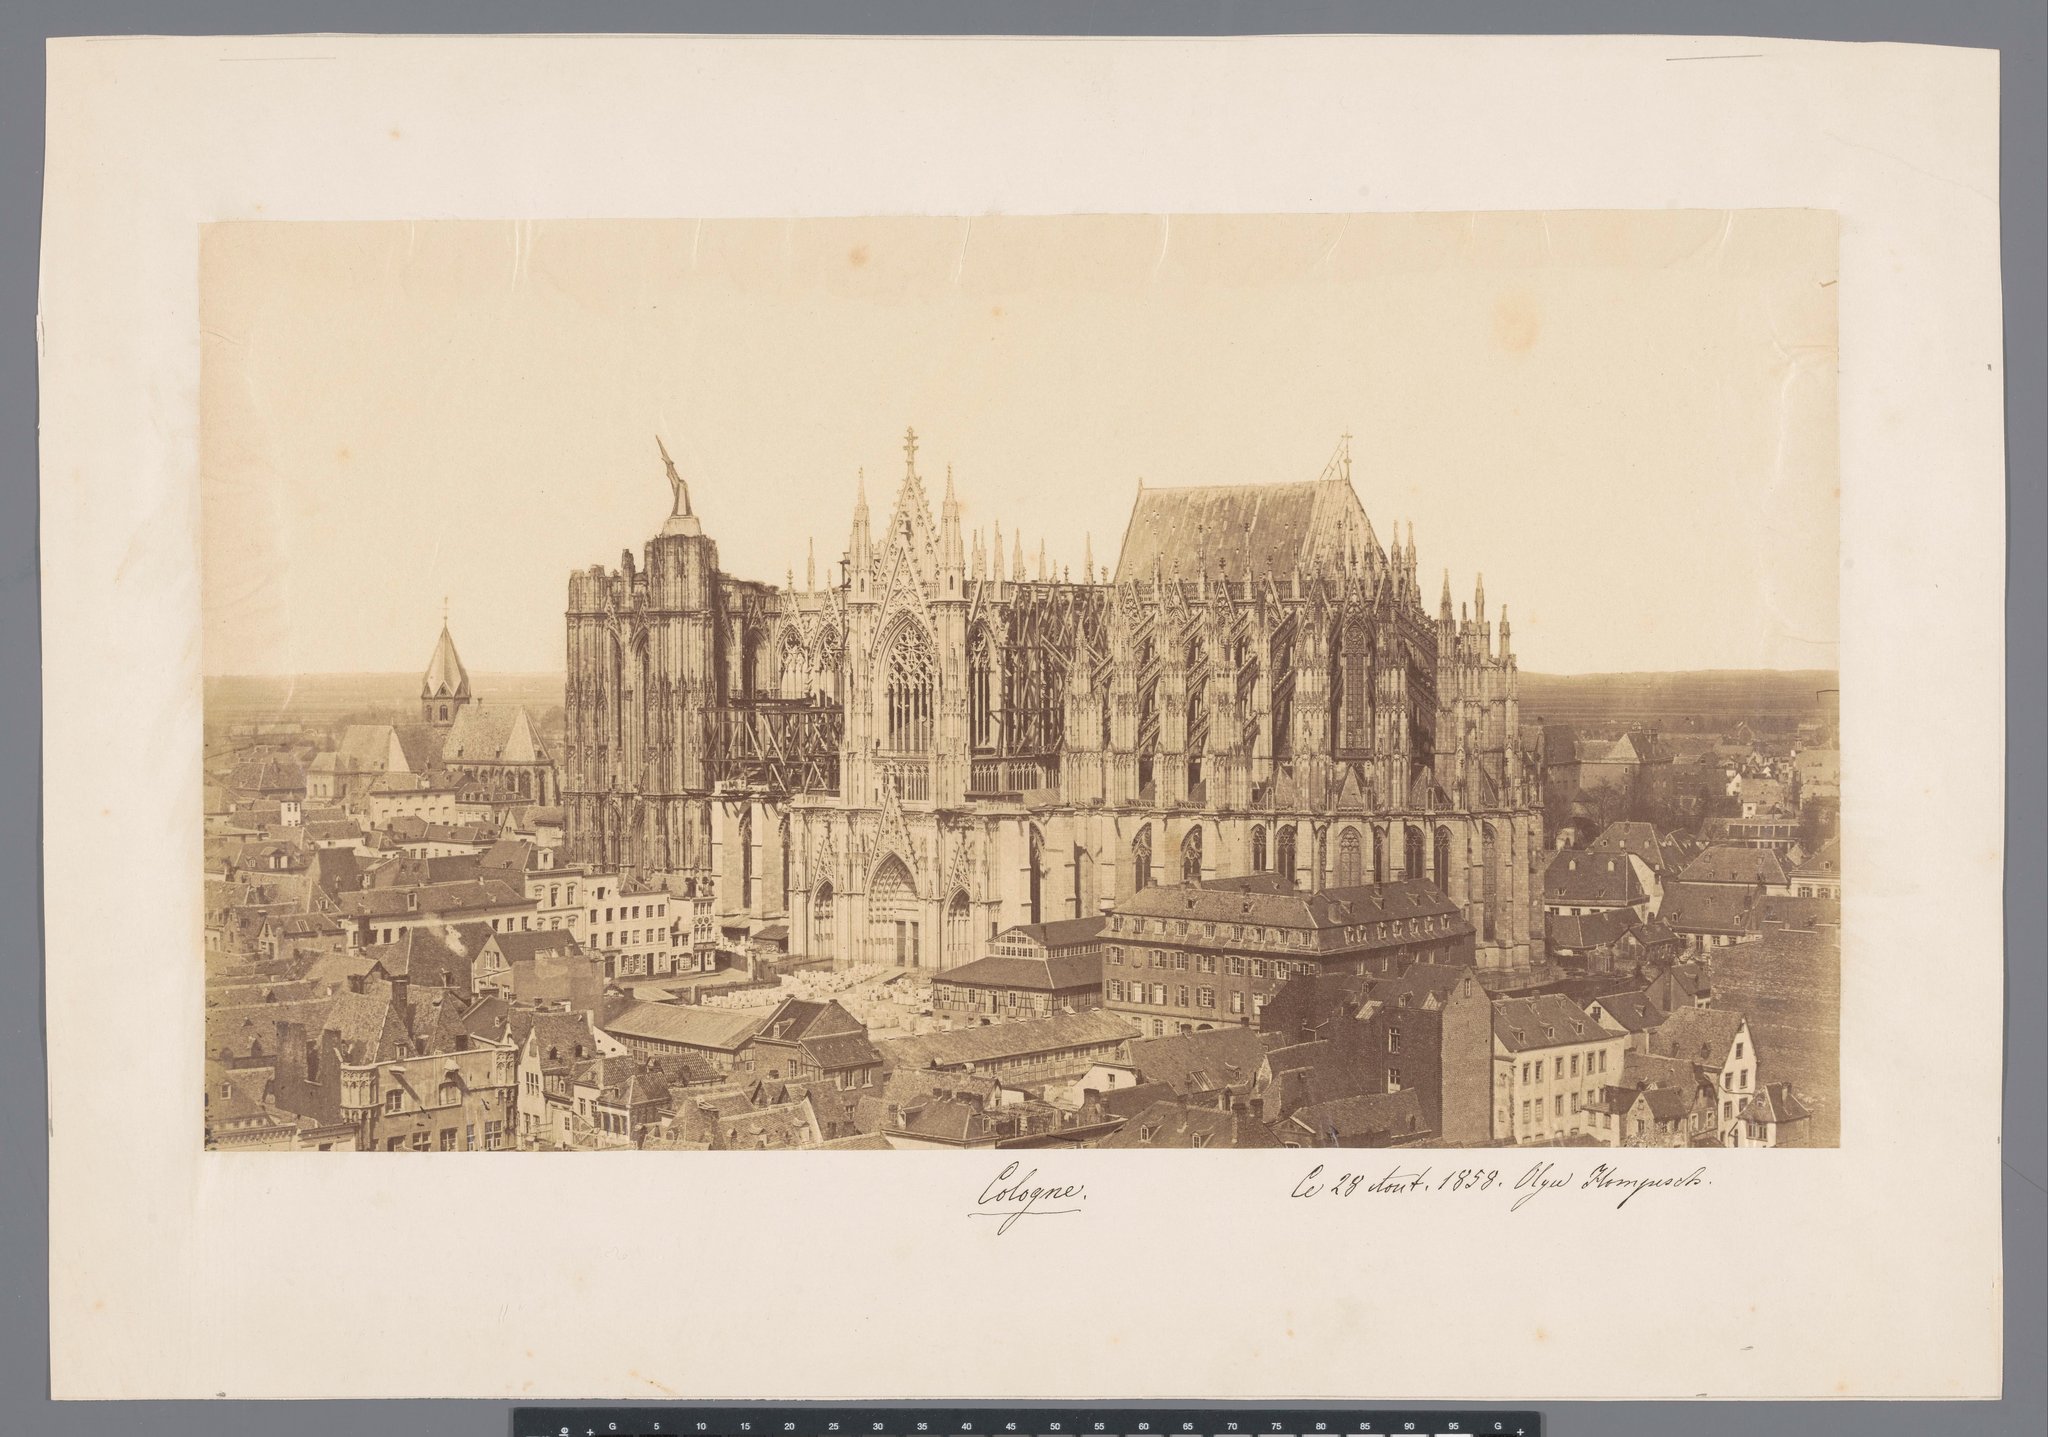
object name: photograph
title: Gezicht op de Dom van Keulen in aanbouw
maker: olga hompesch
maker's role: fotograaf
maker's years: 1824-1902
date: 1858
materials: paper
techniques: salted paper print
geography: cologne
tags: church (exterior), building of church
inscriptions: signature and date: ‘Le 28 Aout 1858. Olga Hompesch’, inscription: ‘Cologne’